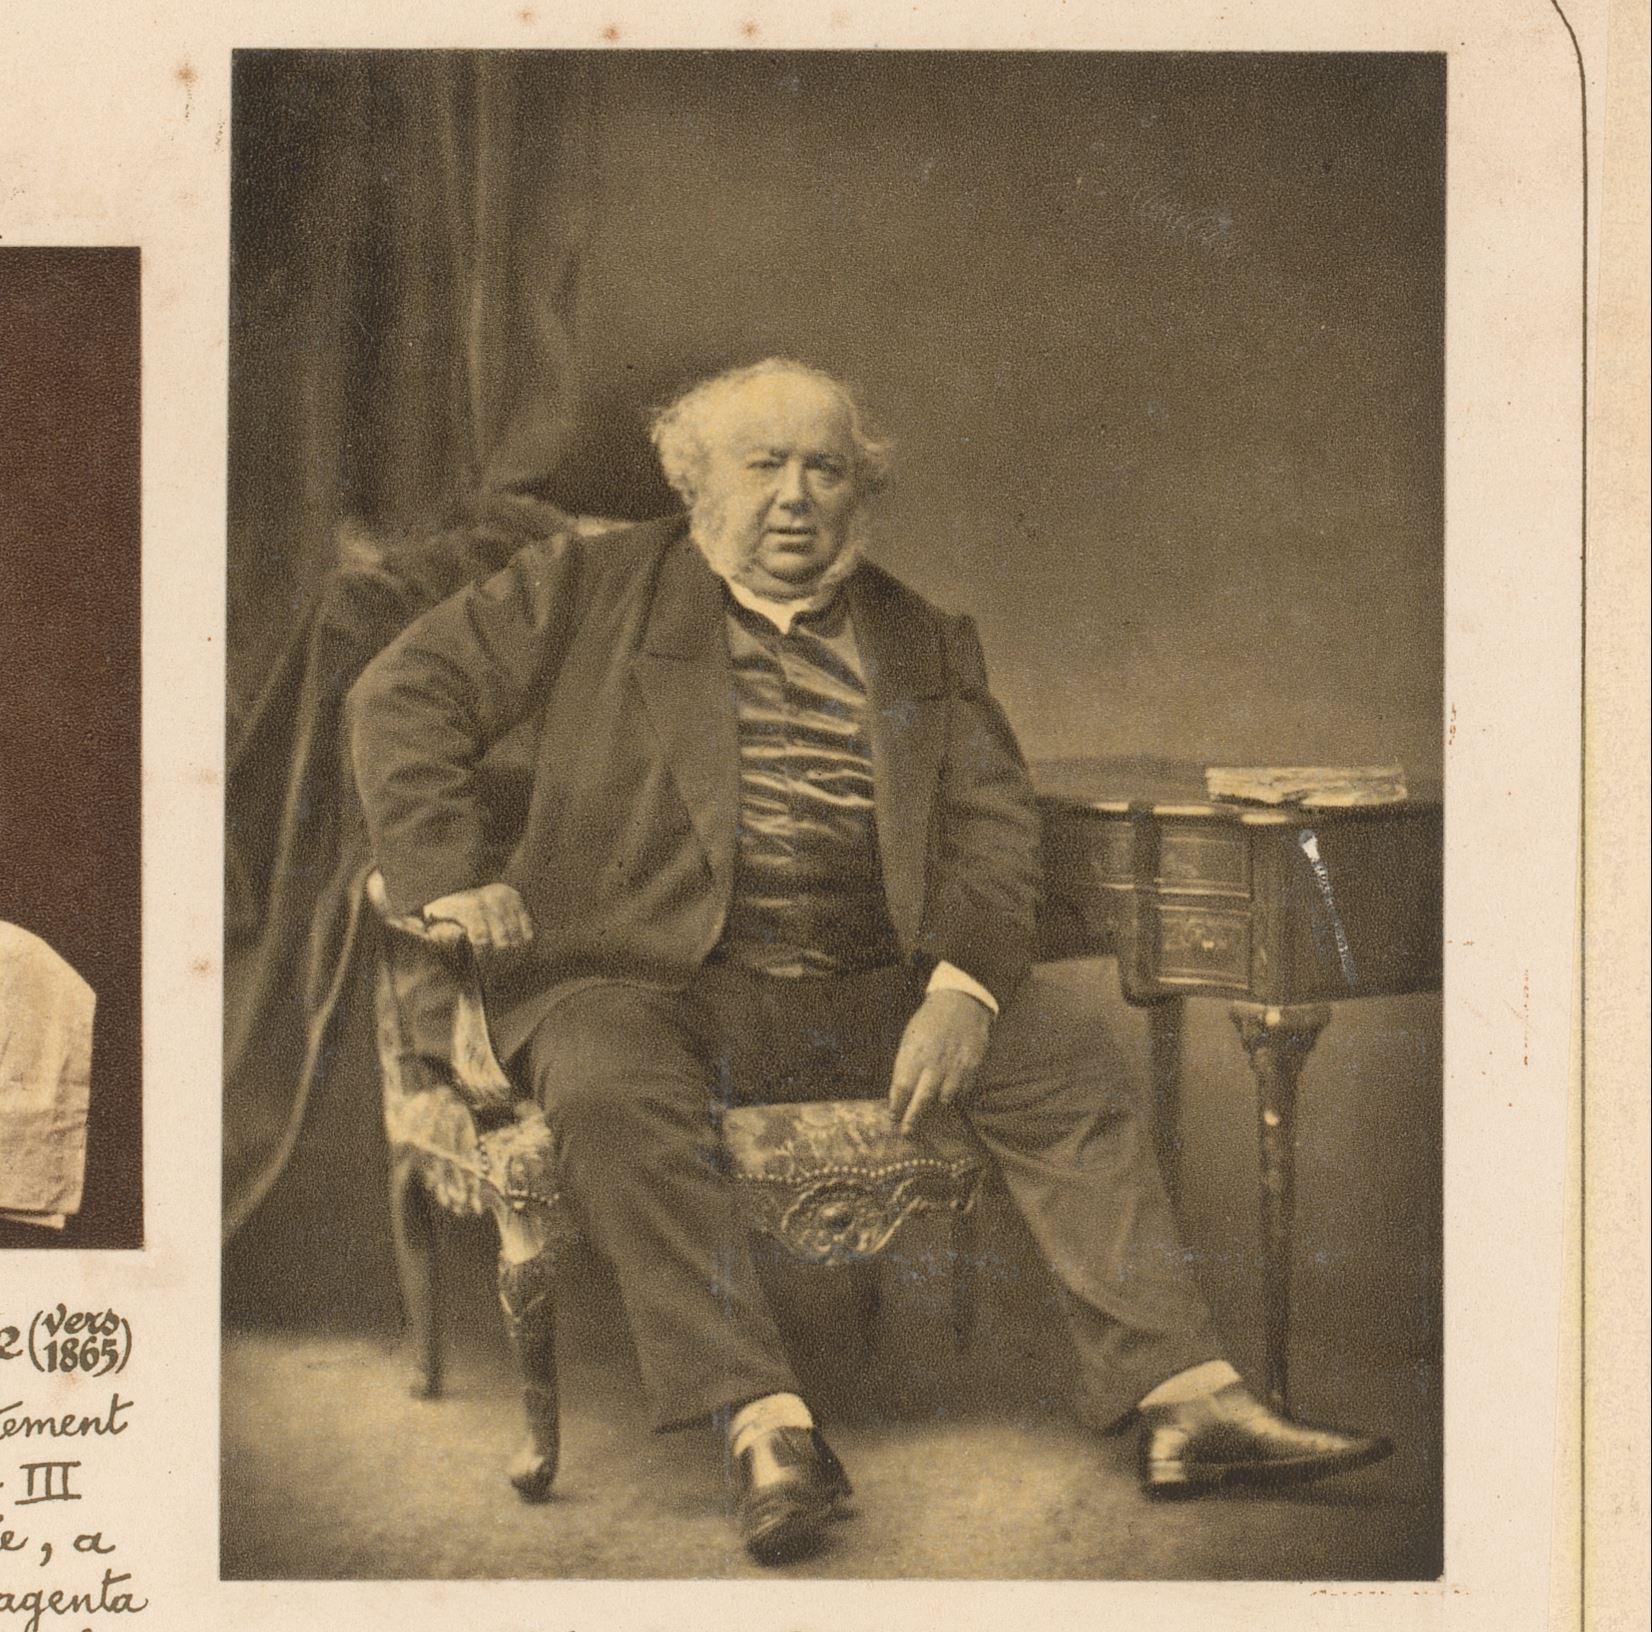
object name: album leaf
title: Jules Janin (en 1870)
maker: Anonymous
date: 1870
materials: paper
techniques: rotogravure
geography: france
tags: jules gabriel janin, writer, poet, author, france